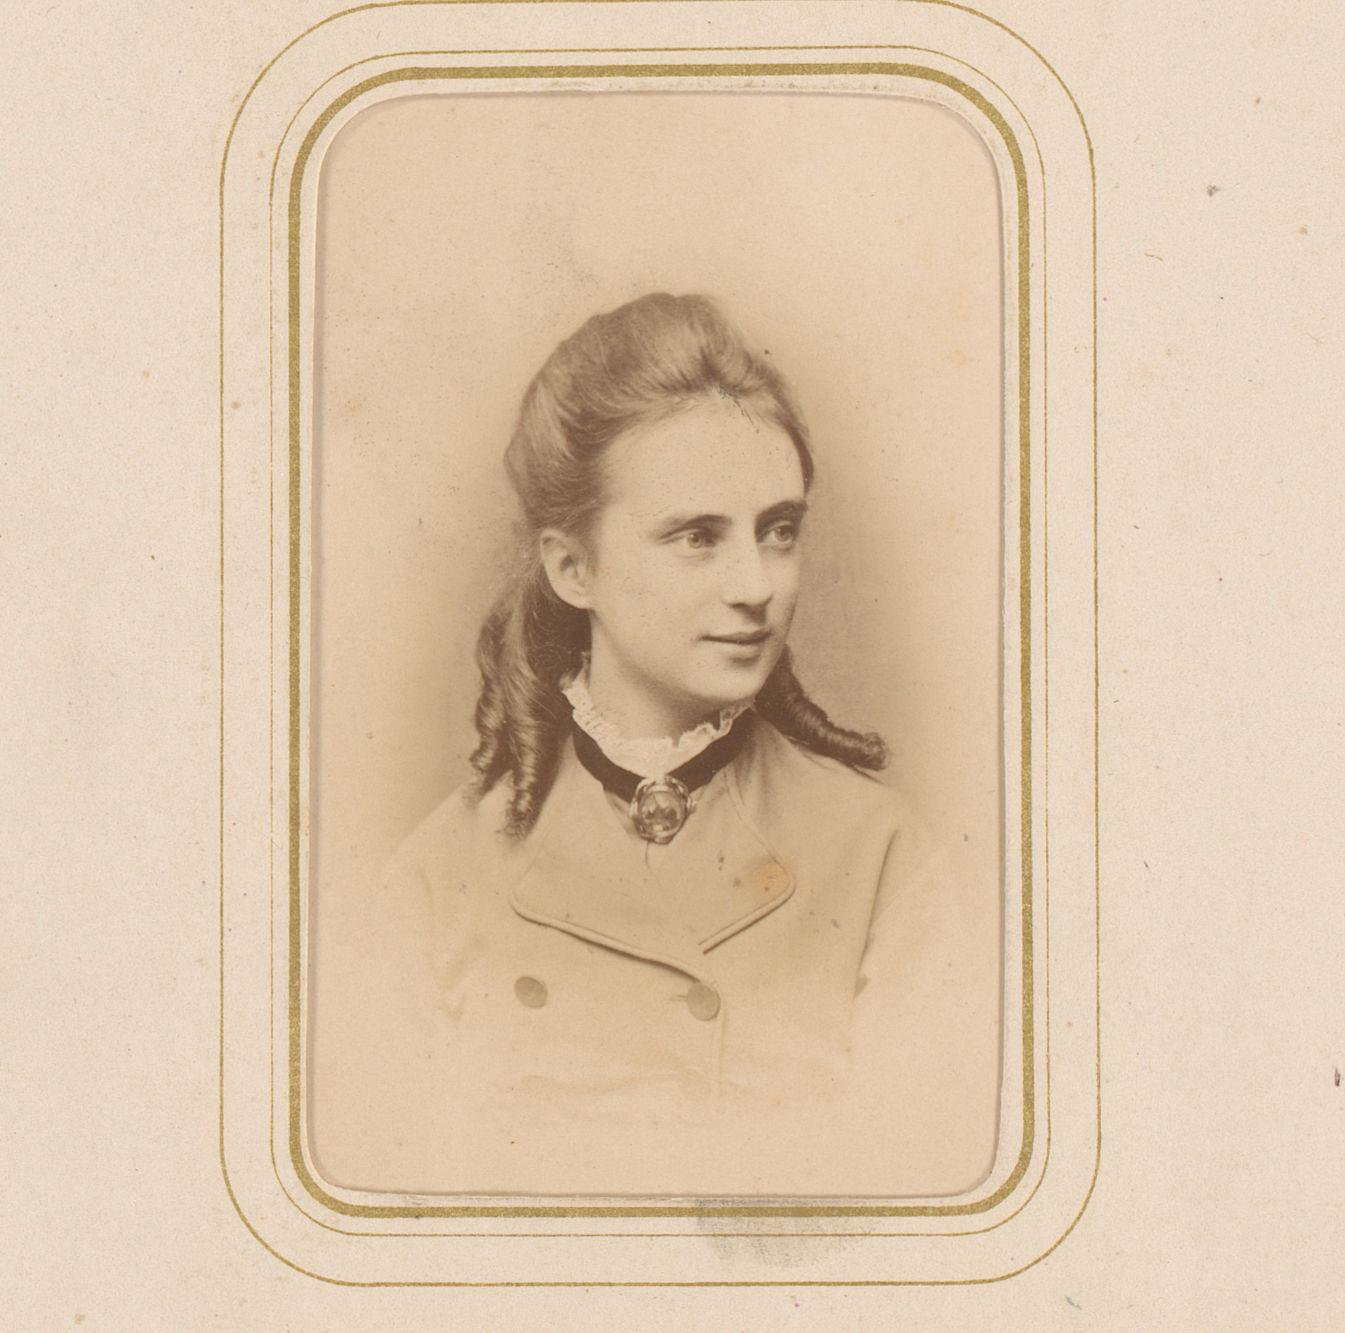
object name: photograph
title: Portret van een meisje met halsketting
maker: a.h. burdorf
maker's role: fotograaf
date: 1876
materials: cardboard, photographic support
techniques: albumen print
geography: hildesheim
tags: historical persons - bb - woman, girl (child between toddler and youth), necklace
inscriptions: annotation: ‘1876/ Hildesheim’, date: ‘1876’, inscription: ‘Photographisches/ Atelier/ von/ A. H. Burdorf/ Hildesheim/ Neue Osterstrasse/ No 10./ (...)’